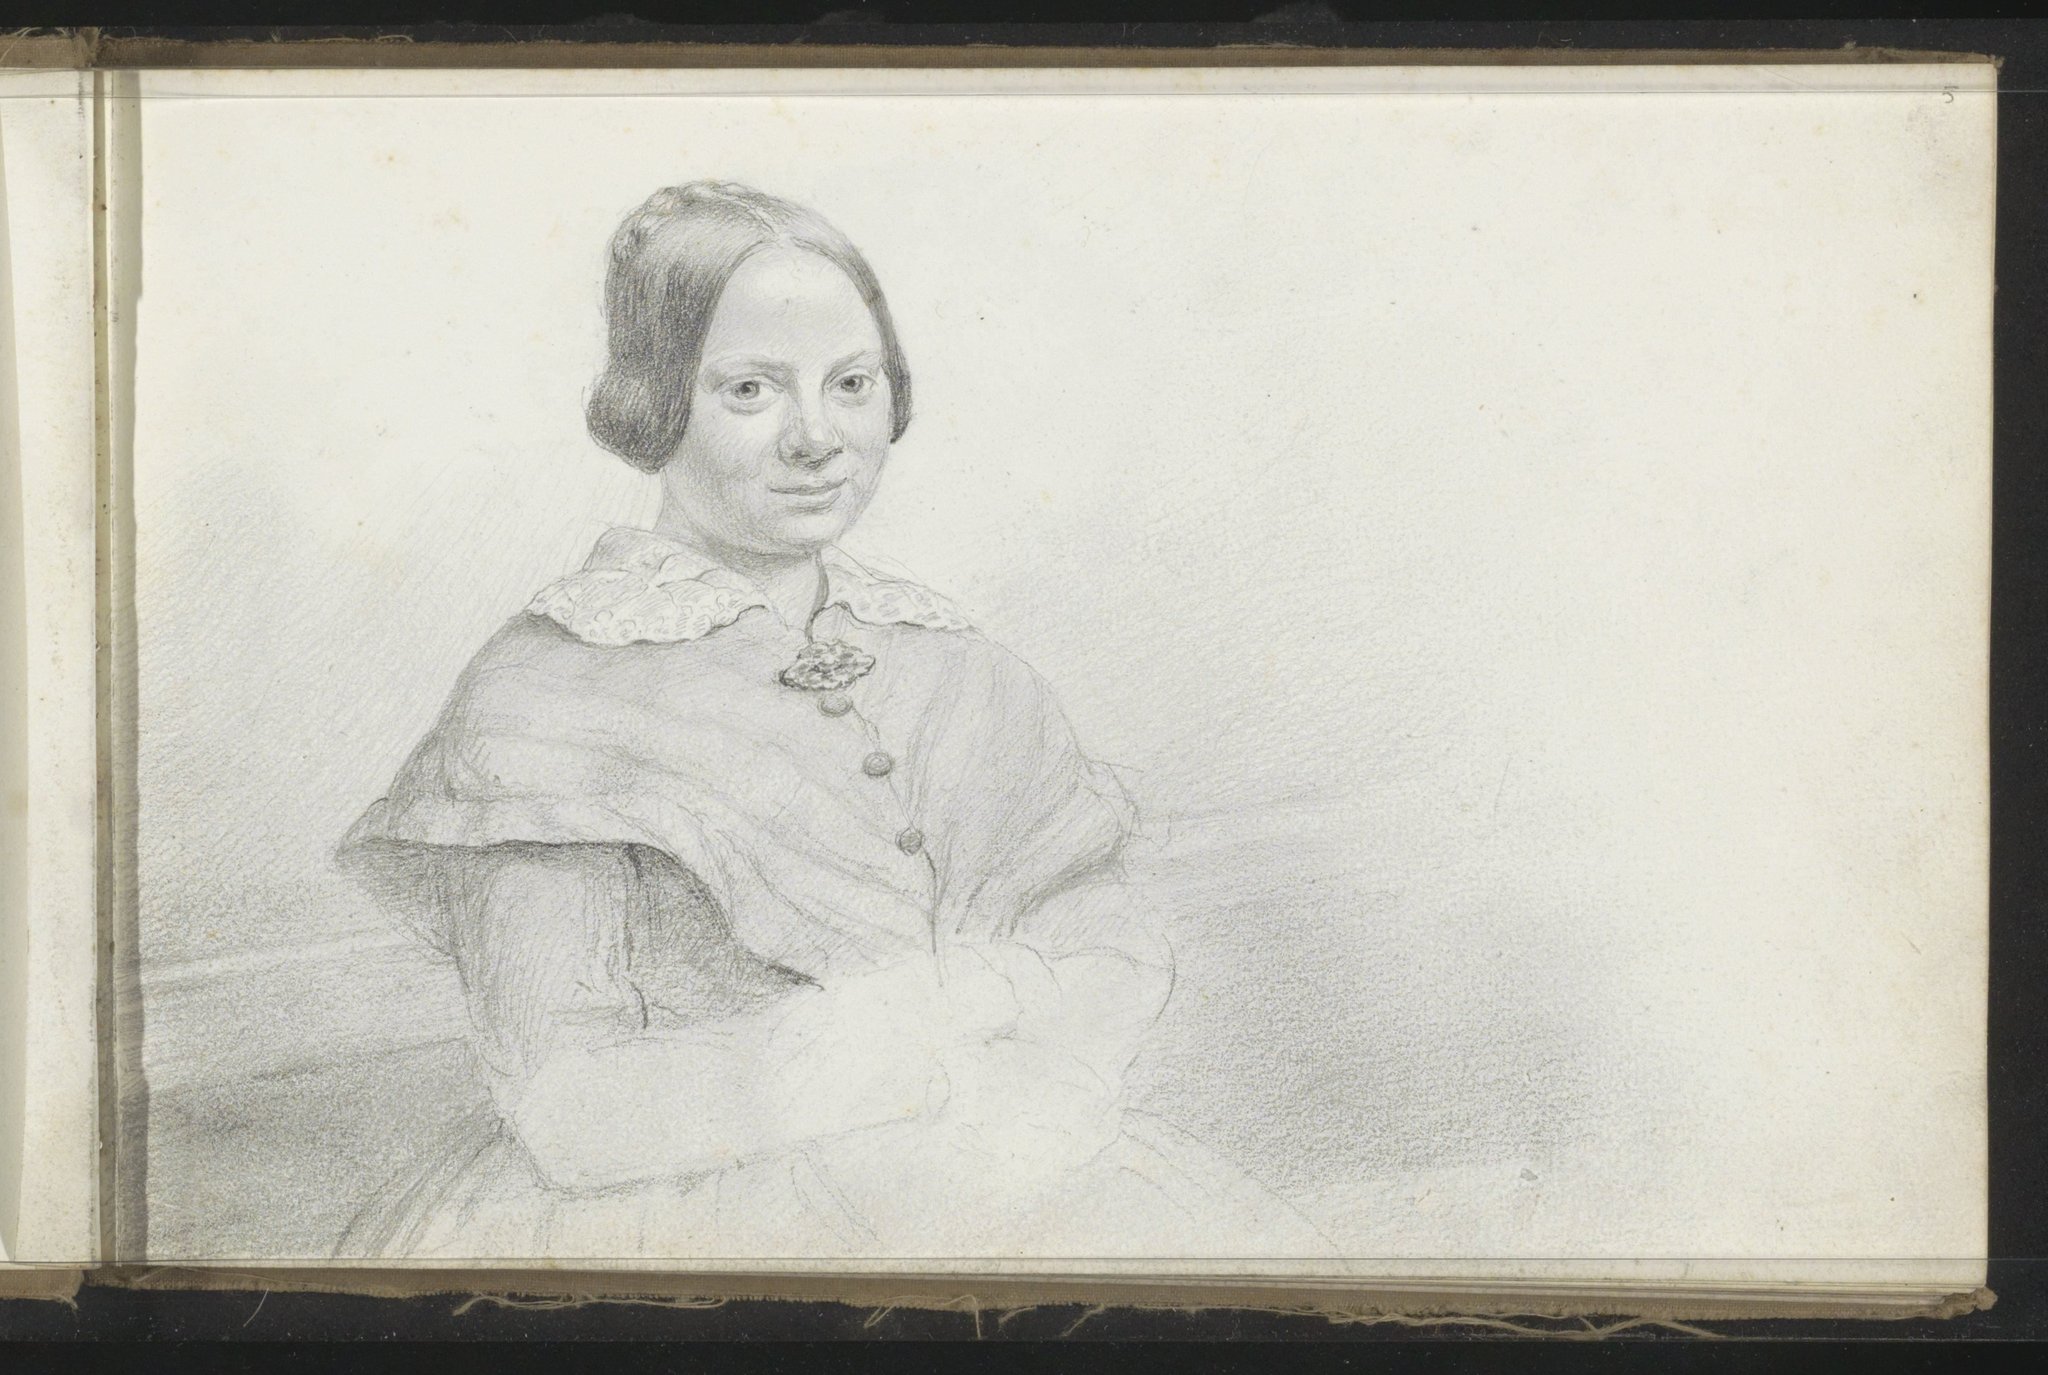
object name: sketchbook leaf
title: Portret van een vrouw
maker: christian heinrich gottlieb steuerwald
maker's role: draughtsman, print maker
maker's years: 1802-1874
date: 1848-1854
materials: paper, pencil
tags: anonymous historical person portrayed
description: Blad 5 recto uit een schetsboek met 58 bladen.